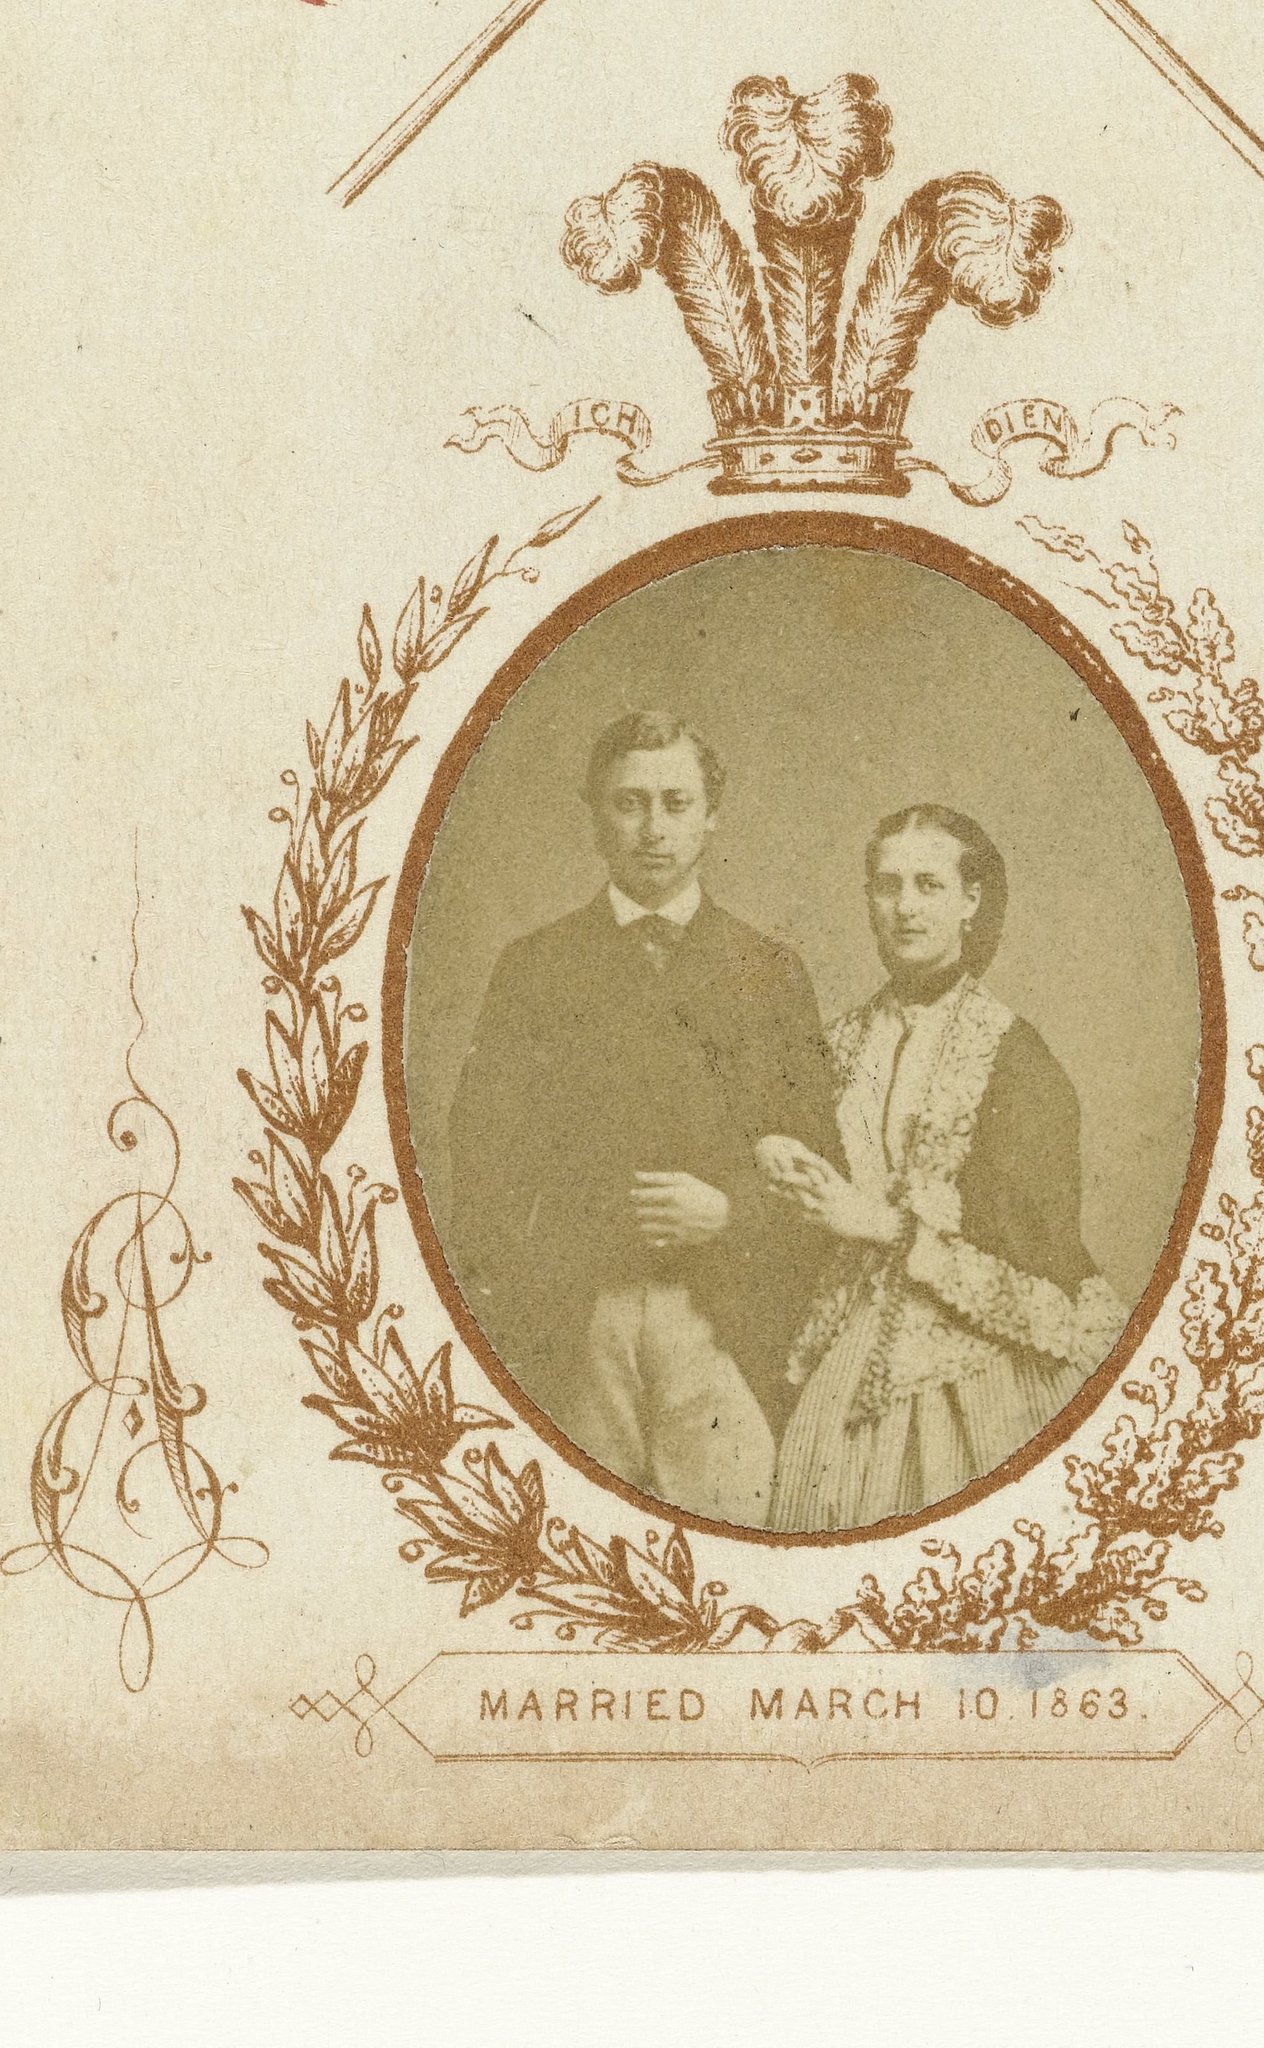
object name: carte de visite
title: Huwelijksportret van Edward, Prince of Wales en Alexandra van Denemarken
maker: Anonymous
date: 1863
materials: cardboard, paper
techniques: albumen print, lithograph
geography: england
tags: copenhagen (city), historical persons - bb - woman, historical persons, (civil) marriage ceremonies, public festivities at marriage of royal persons, england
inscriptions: annotation: ‘MARRIED MARCH 10 1863’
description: Edward, Prince of Wales (later koning Edward VII) en Alexandra van Denemarken in gekroond ovaal waarboven gekruist de Engelse en Deense vlag.